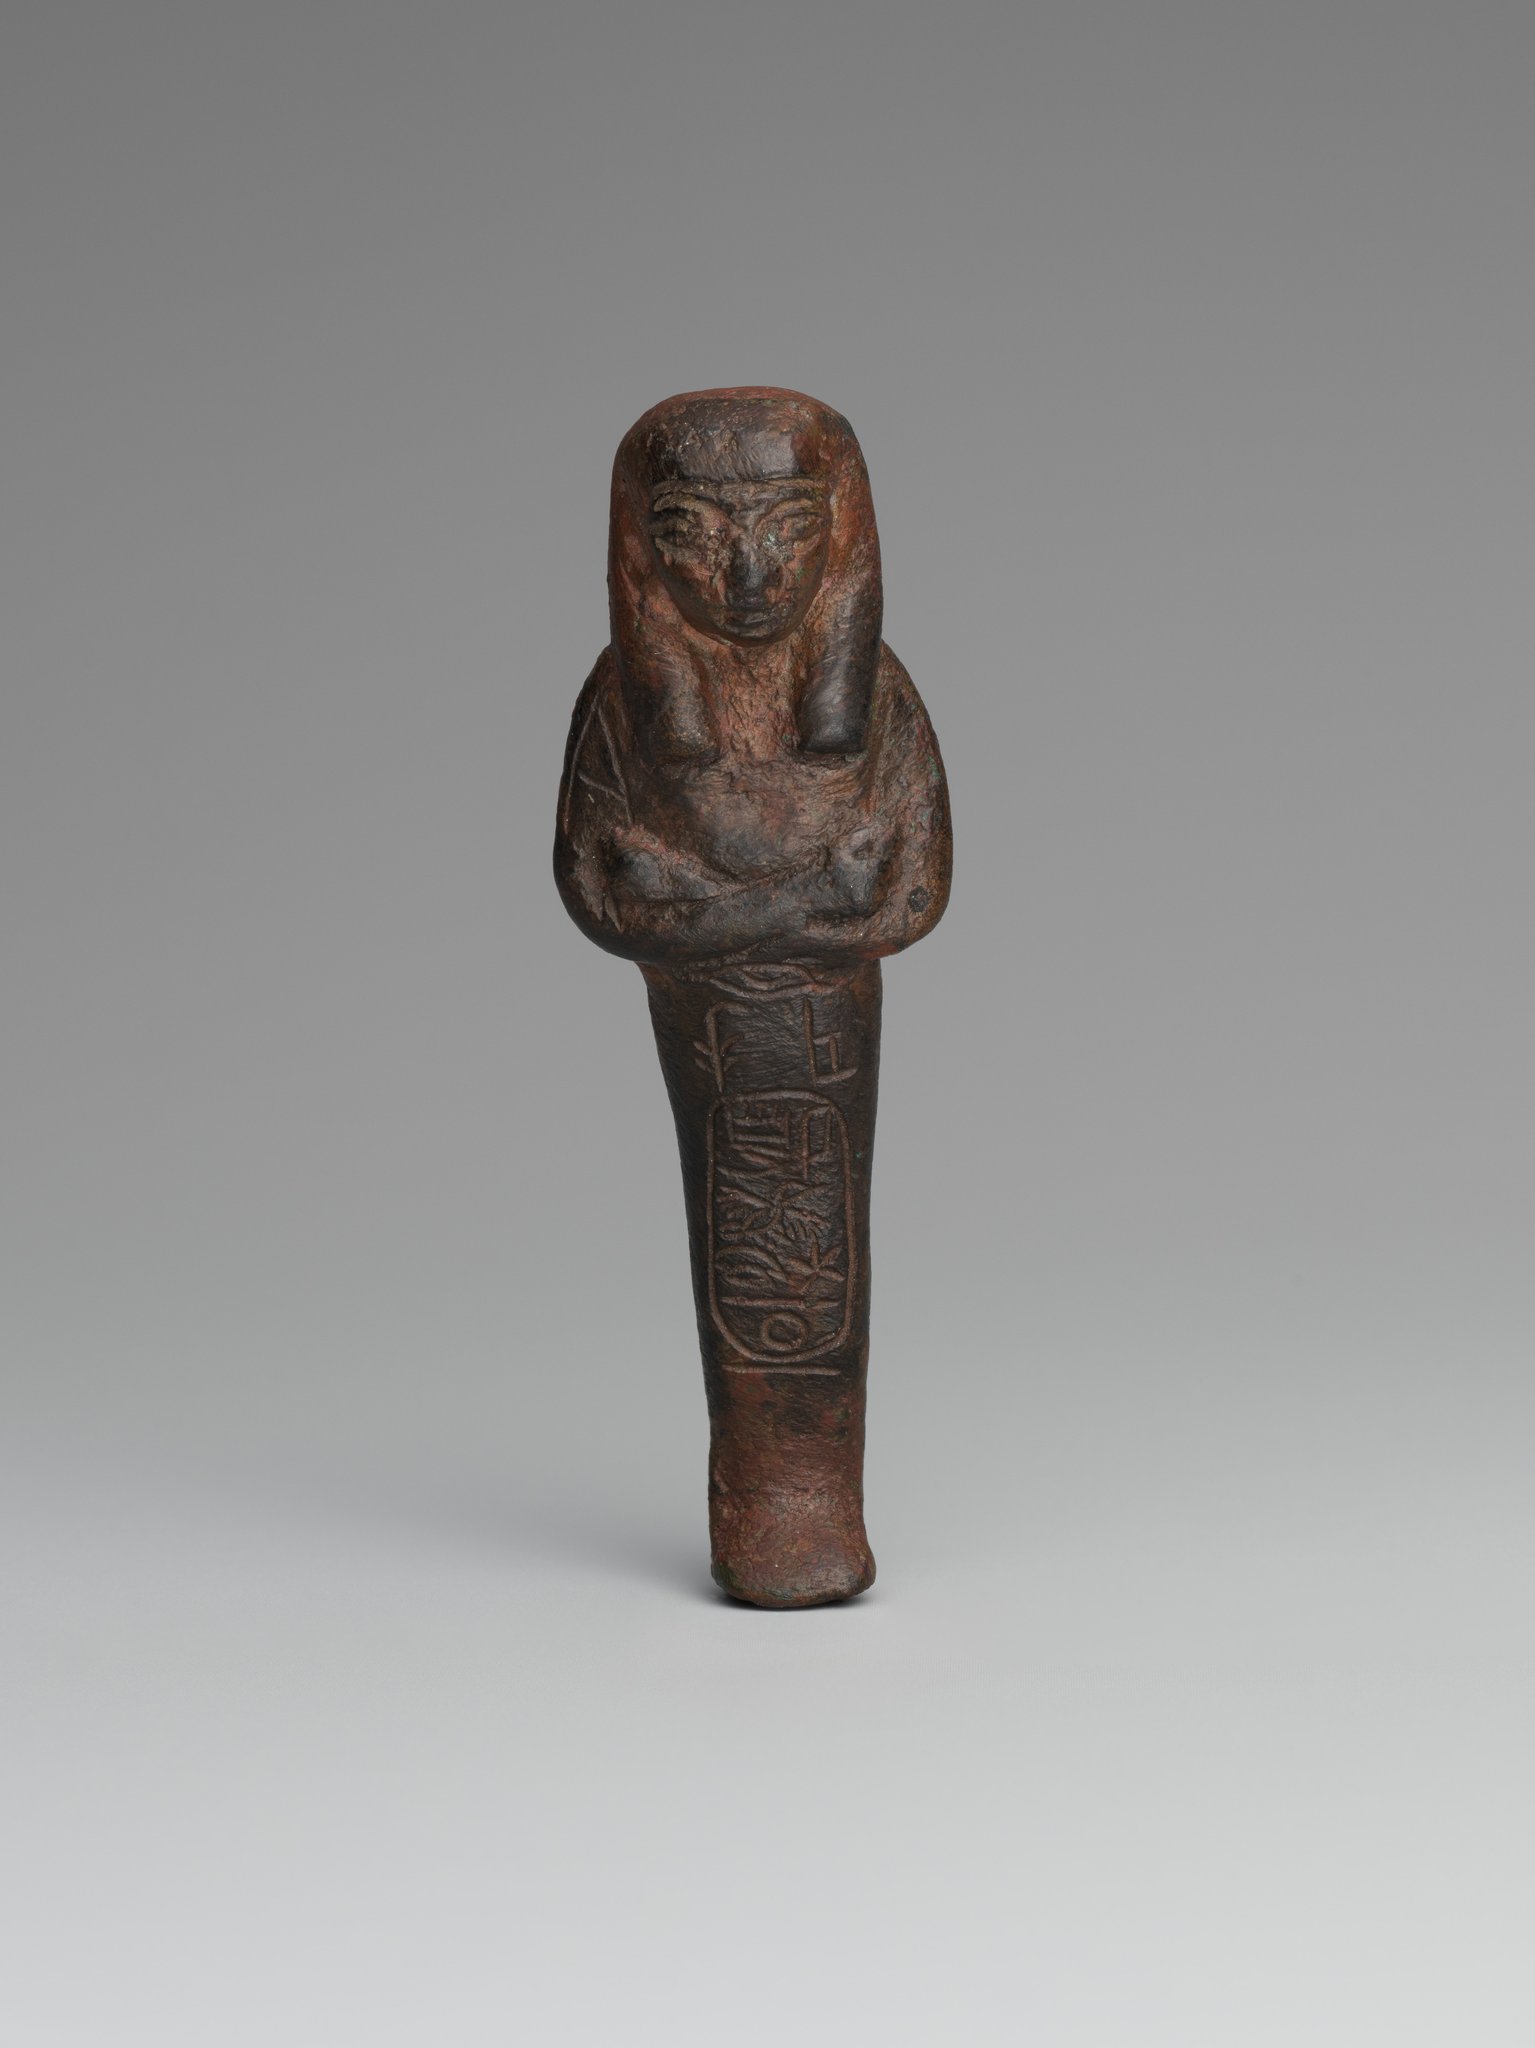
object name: shabti, psusennes i, worker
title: Shabti of Psusennes I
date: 1040-992 BCE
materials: bronze, copper alloy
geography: egypt